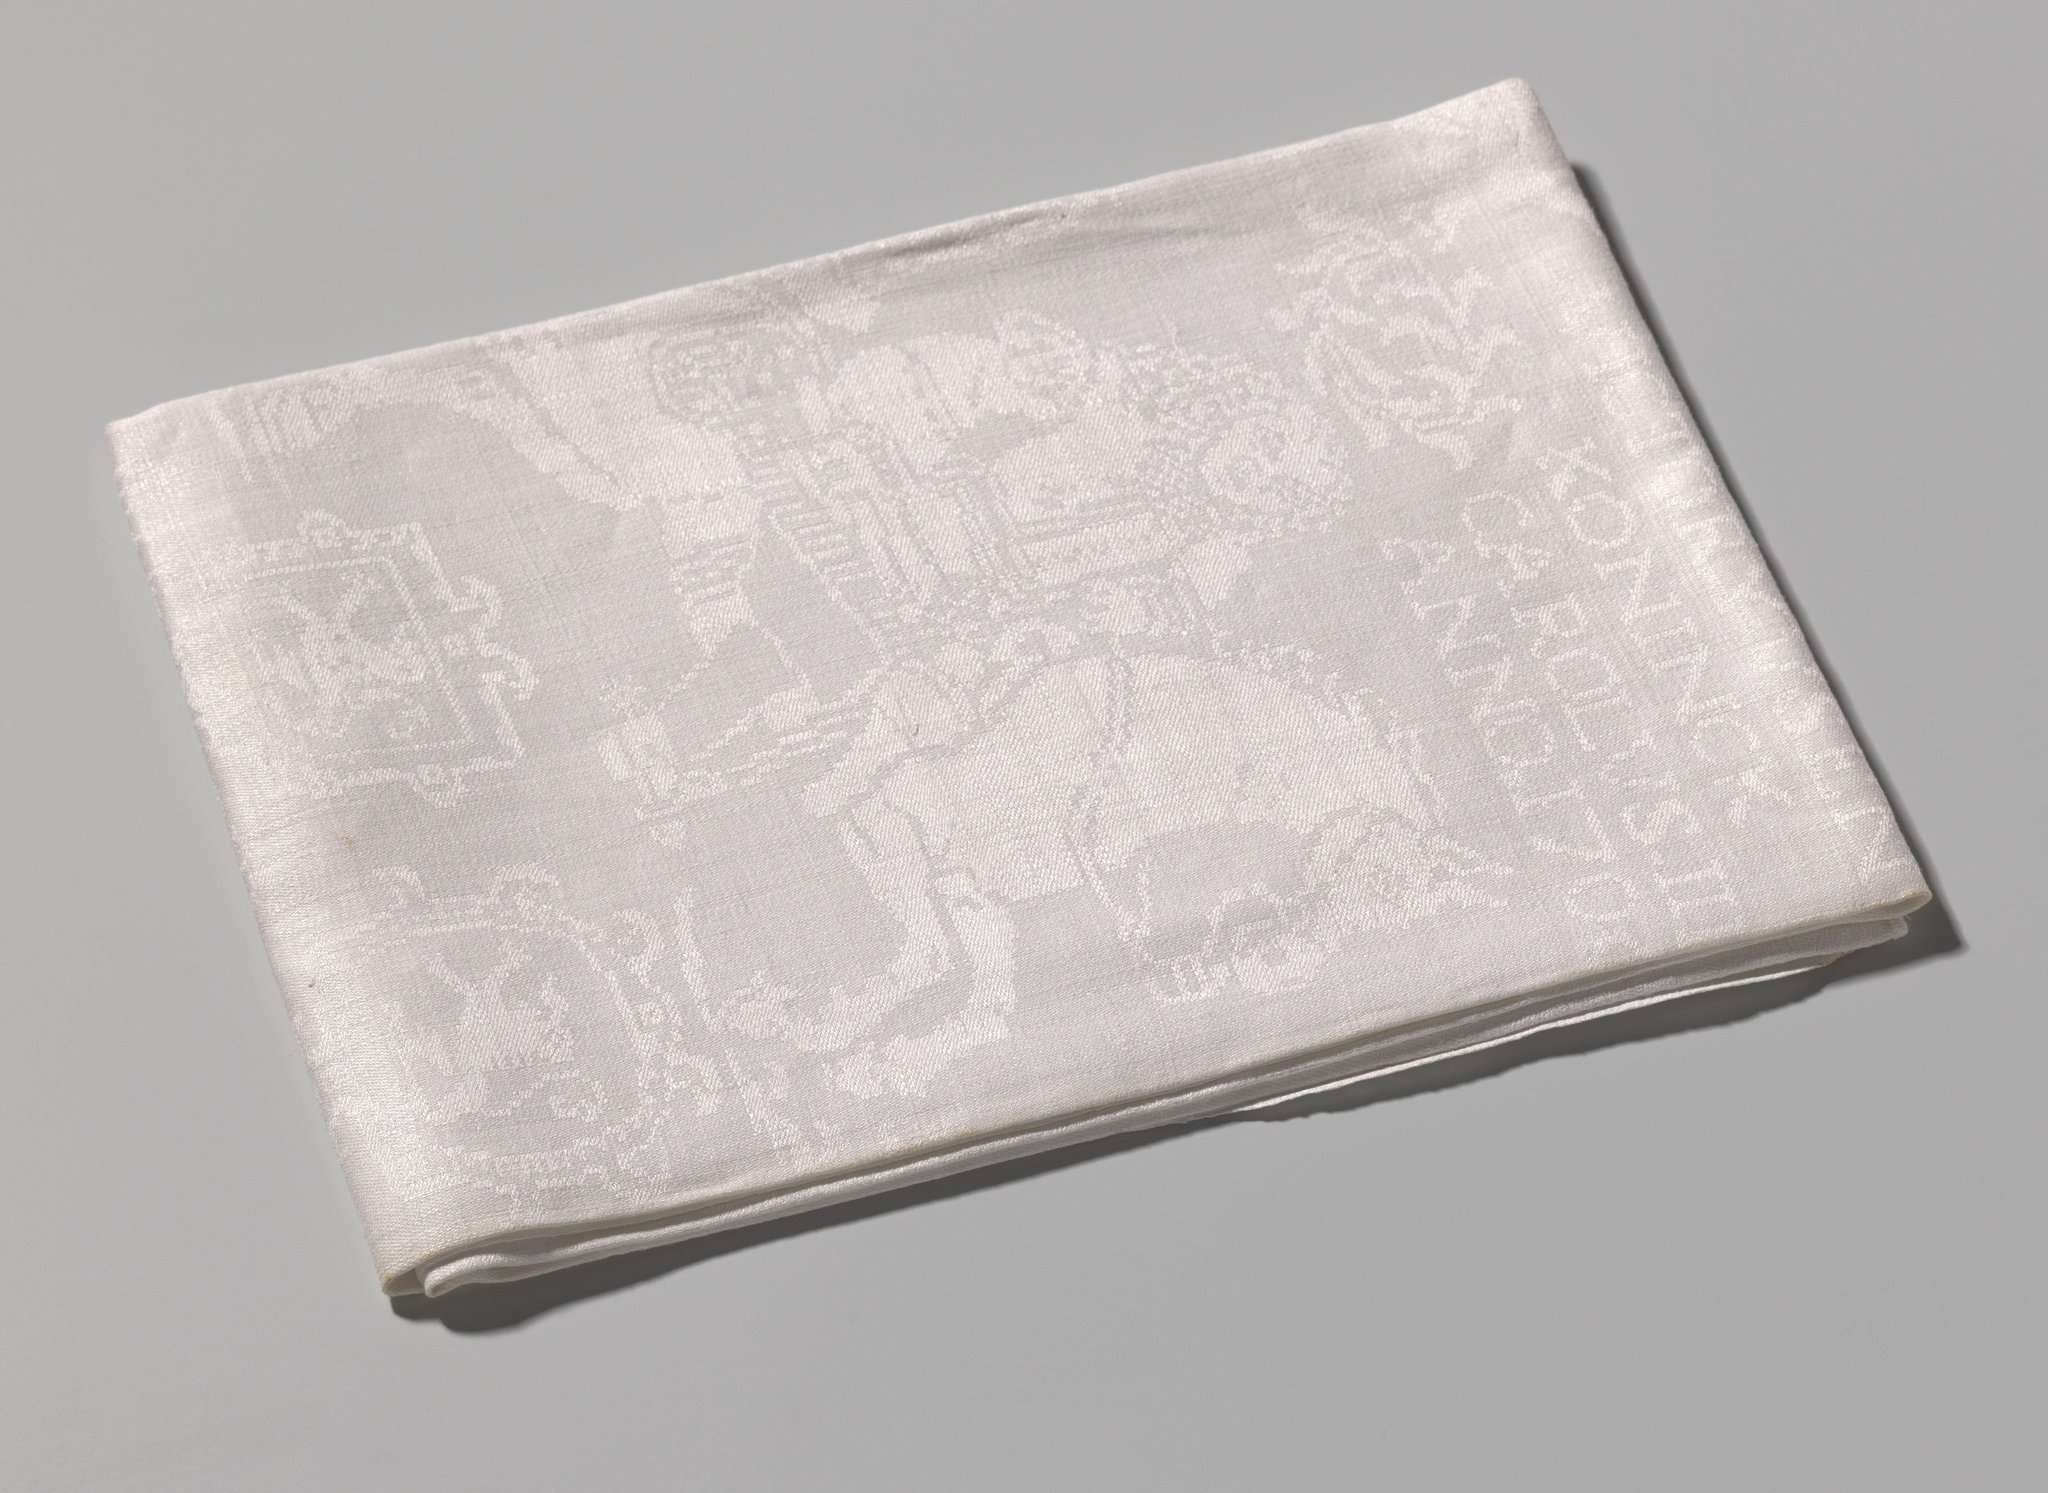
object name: napkin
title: Servet van linnendamast met een historisch tafereel.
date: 1706-1725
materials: linen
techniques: damask, weave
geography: flanders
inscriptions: mark: ‘MVM 12 IVB’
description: Servet van linnendamast met de verheerlijking van Karel III als koning van Spanje na de slag bij Ramilies. Het servet is in rood gemerkt met een kruissteek: MVM 12 FVB en hoort bij een servet met invnr. BK-1977-305-B.